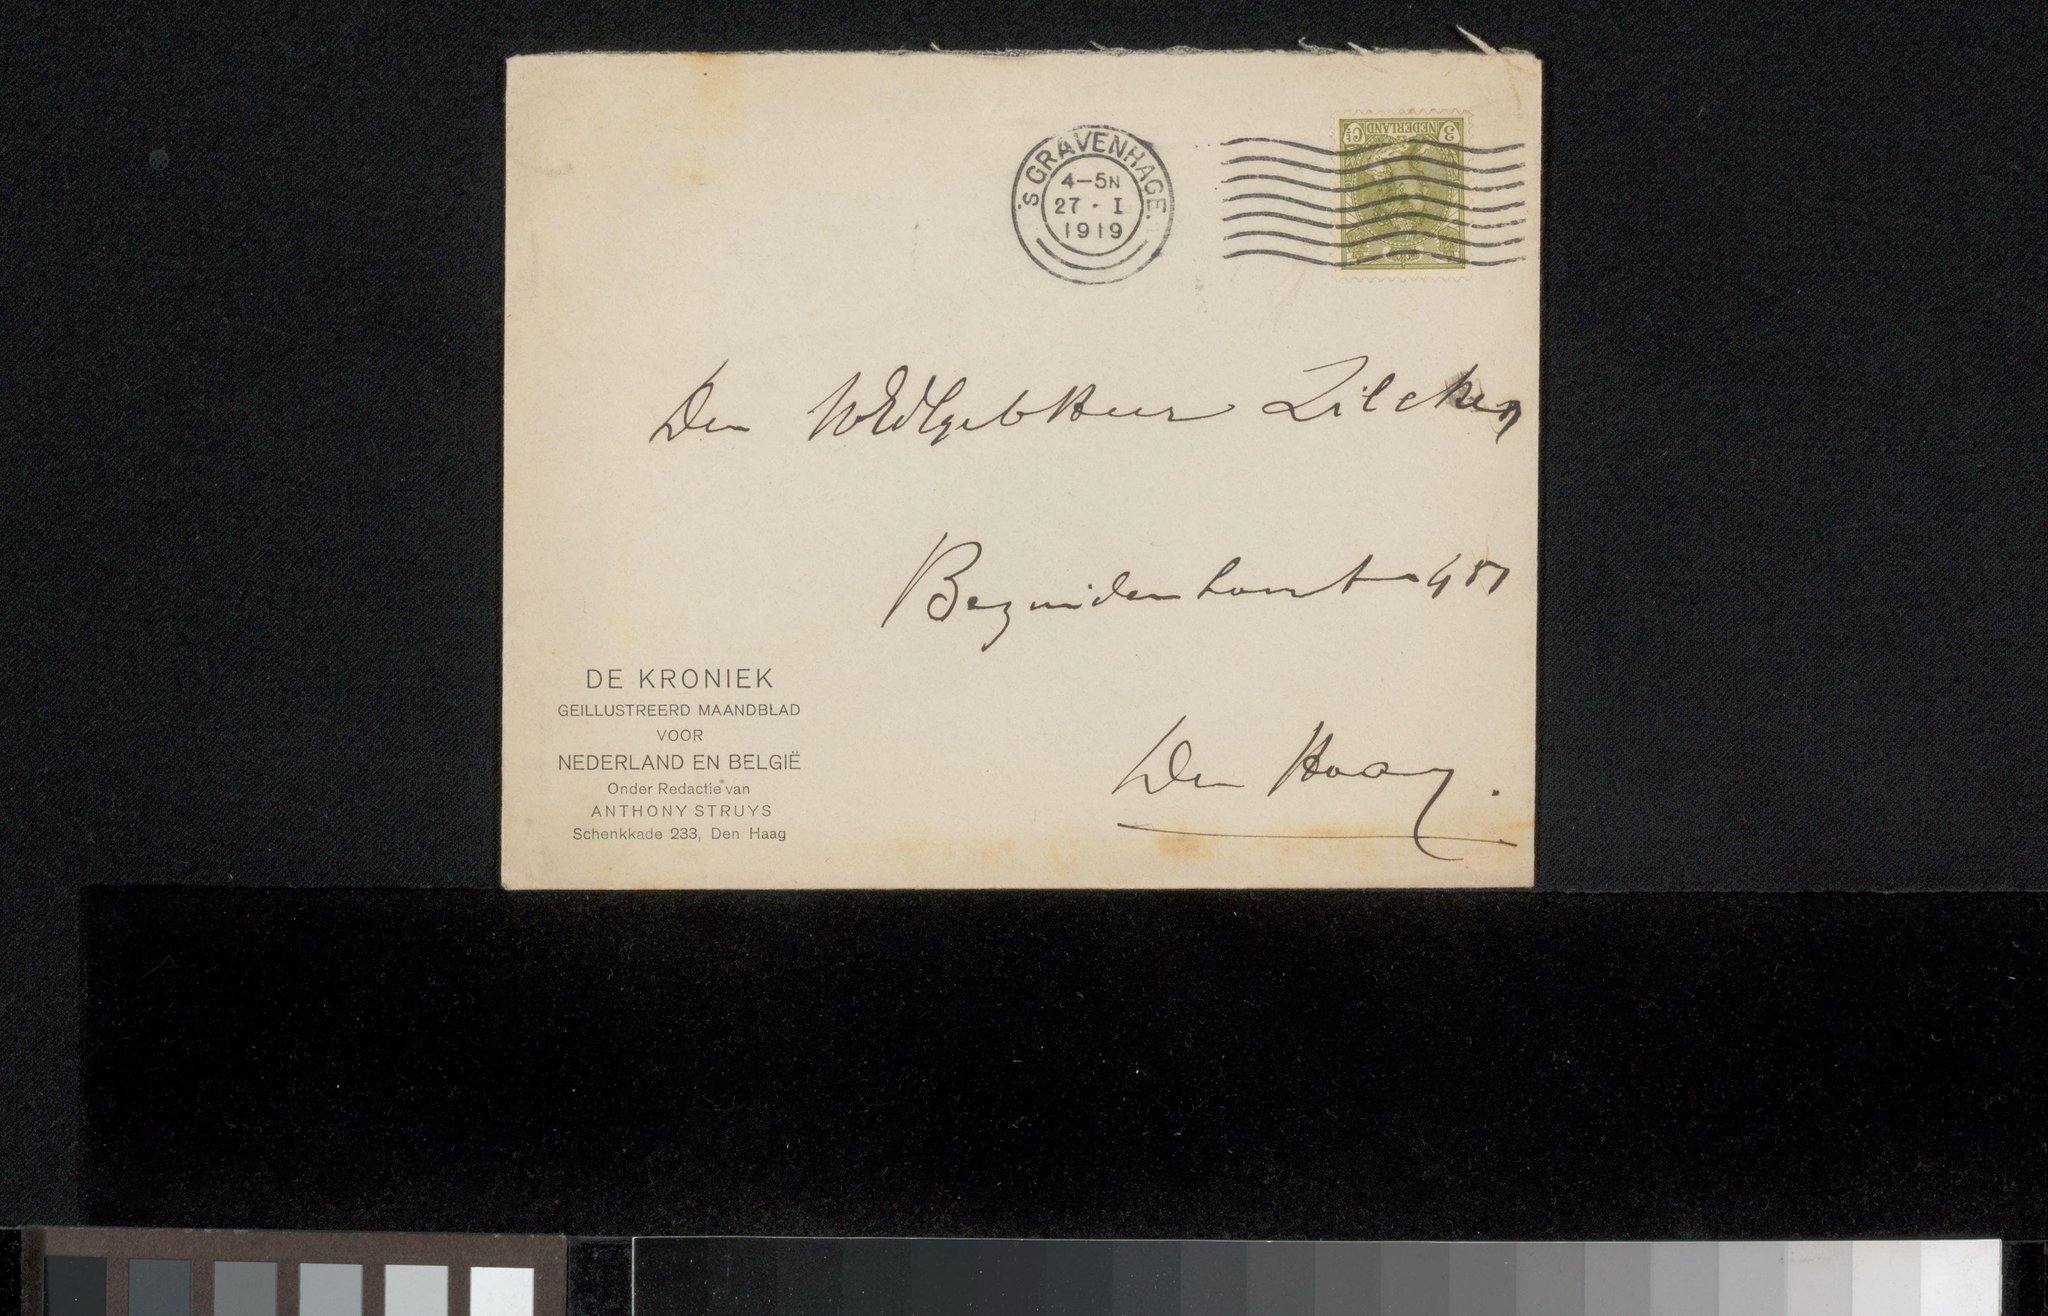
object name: envelope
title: Envelop aan Philip Zilcken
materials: ink, paper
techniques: pen, printing, writing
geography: the hague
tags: the hague, painter, draughtsman, philip zilcken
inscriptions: collector's mark: ‘RPK’